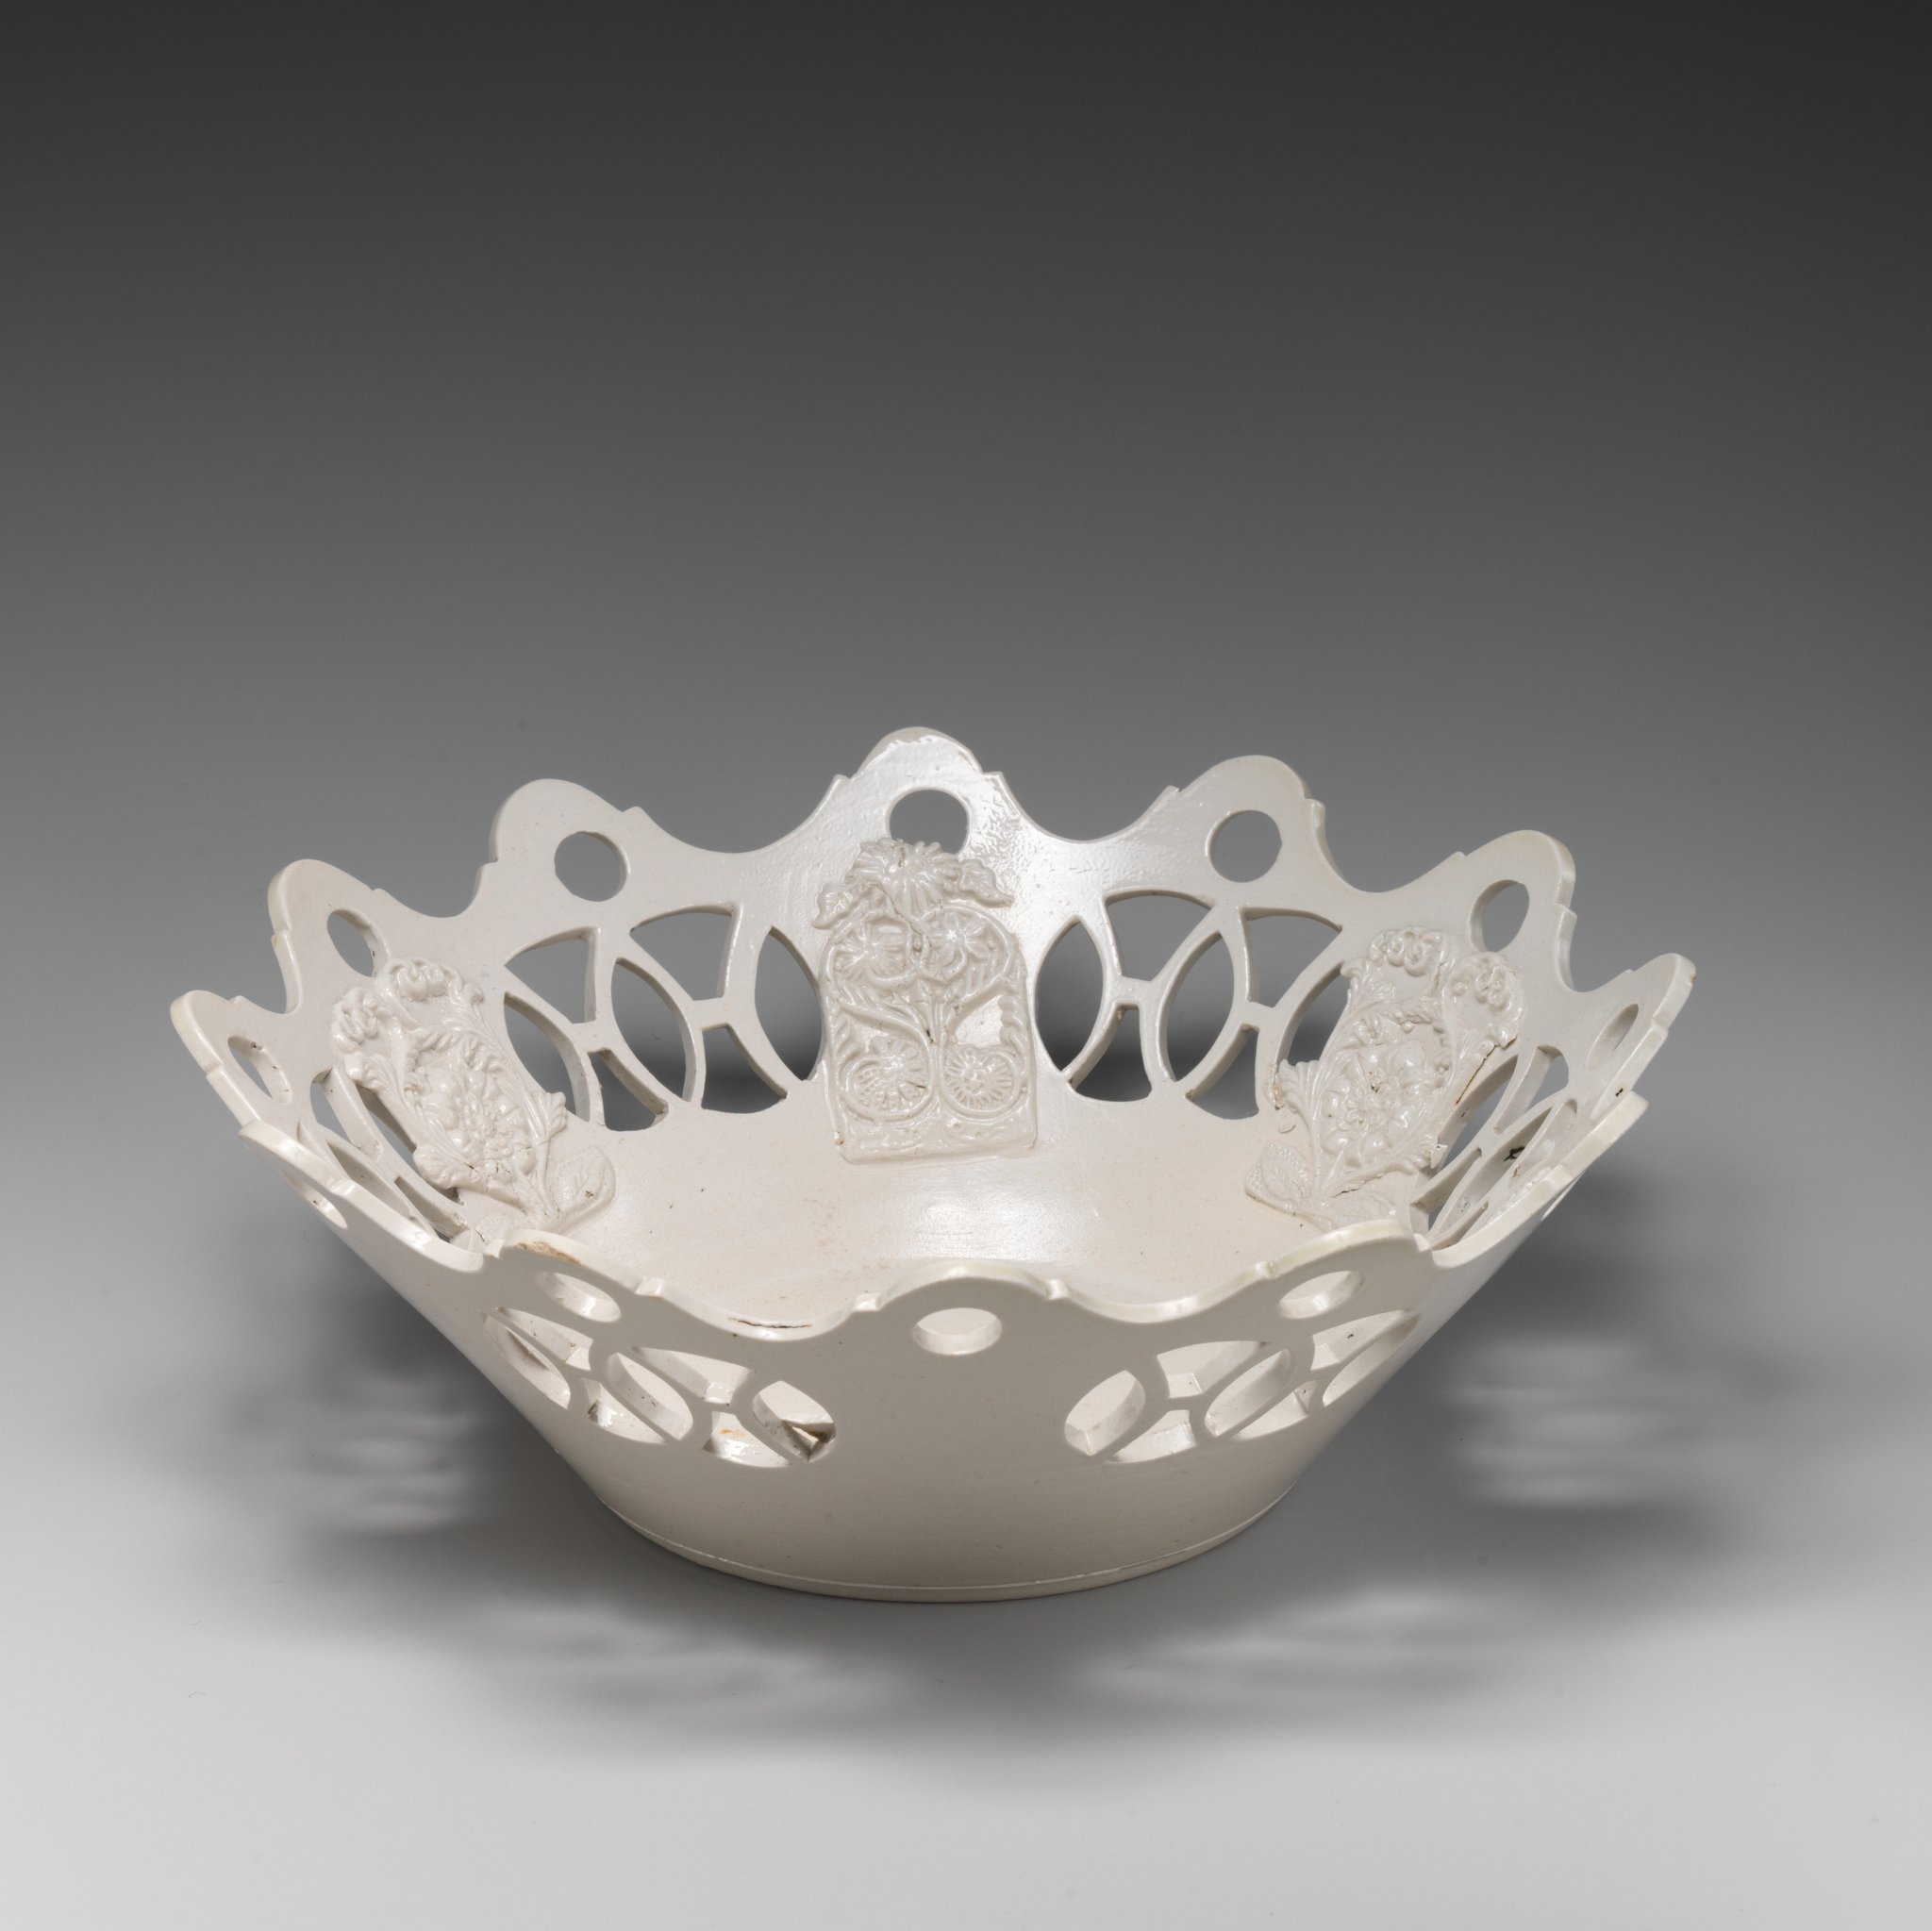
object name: basket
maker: ralph baddeley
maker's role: maker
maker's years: 1700-1800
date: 1760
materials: stoneware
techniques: salt glaze